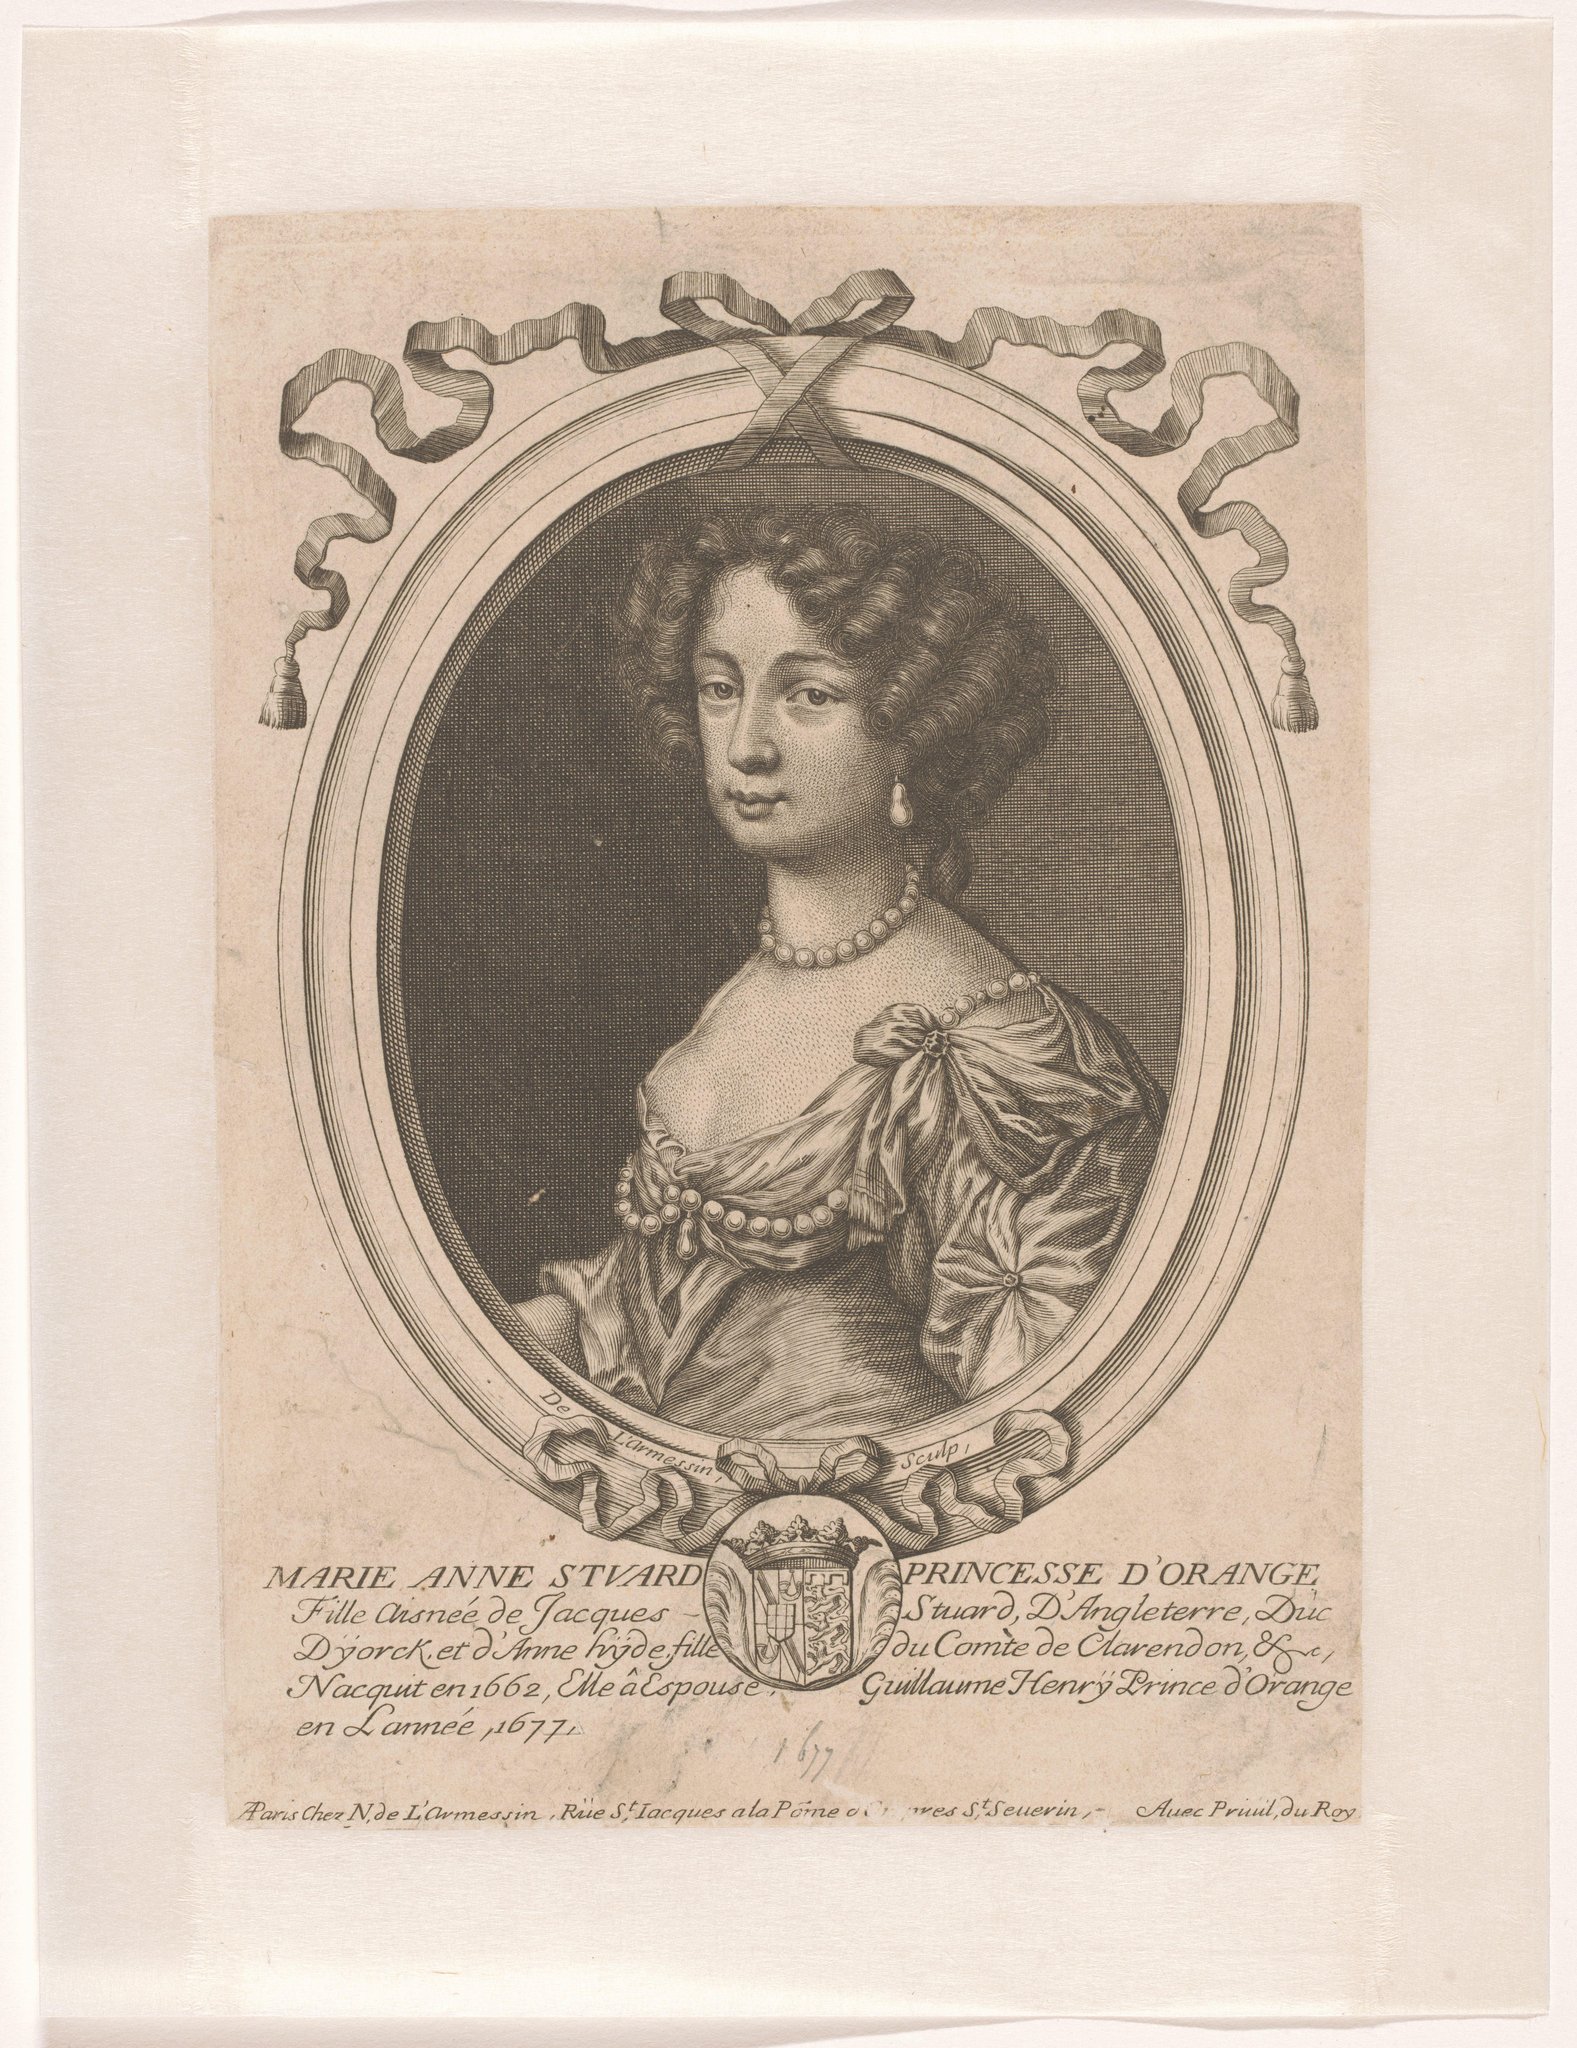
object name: print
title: Marie Anne Stuard Princesse d'Orange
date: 1681-1695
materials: paper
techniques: engraving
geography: paris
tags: london, maria ii stuart (koningin van engeland, schotland en ierland), historical persons - bb - woman, queen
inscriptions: collector's mark: Lugt 2228, collector's mark: Lugt 2760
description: Portret van Maria II Stuart, prinses van Oranje, de latere koningin van Engeland, in 1677 getrouwd met Willem III. Portret in ovaal met linten en vierregelig Frans onderschrift.